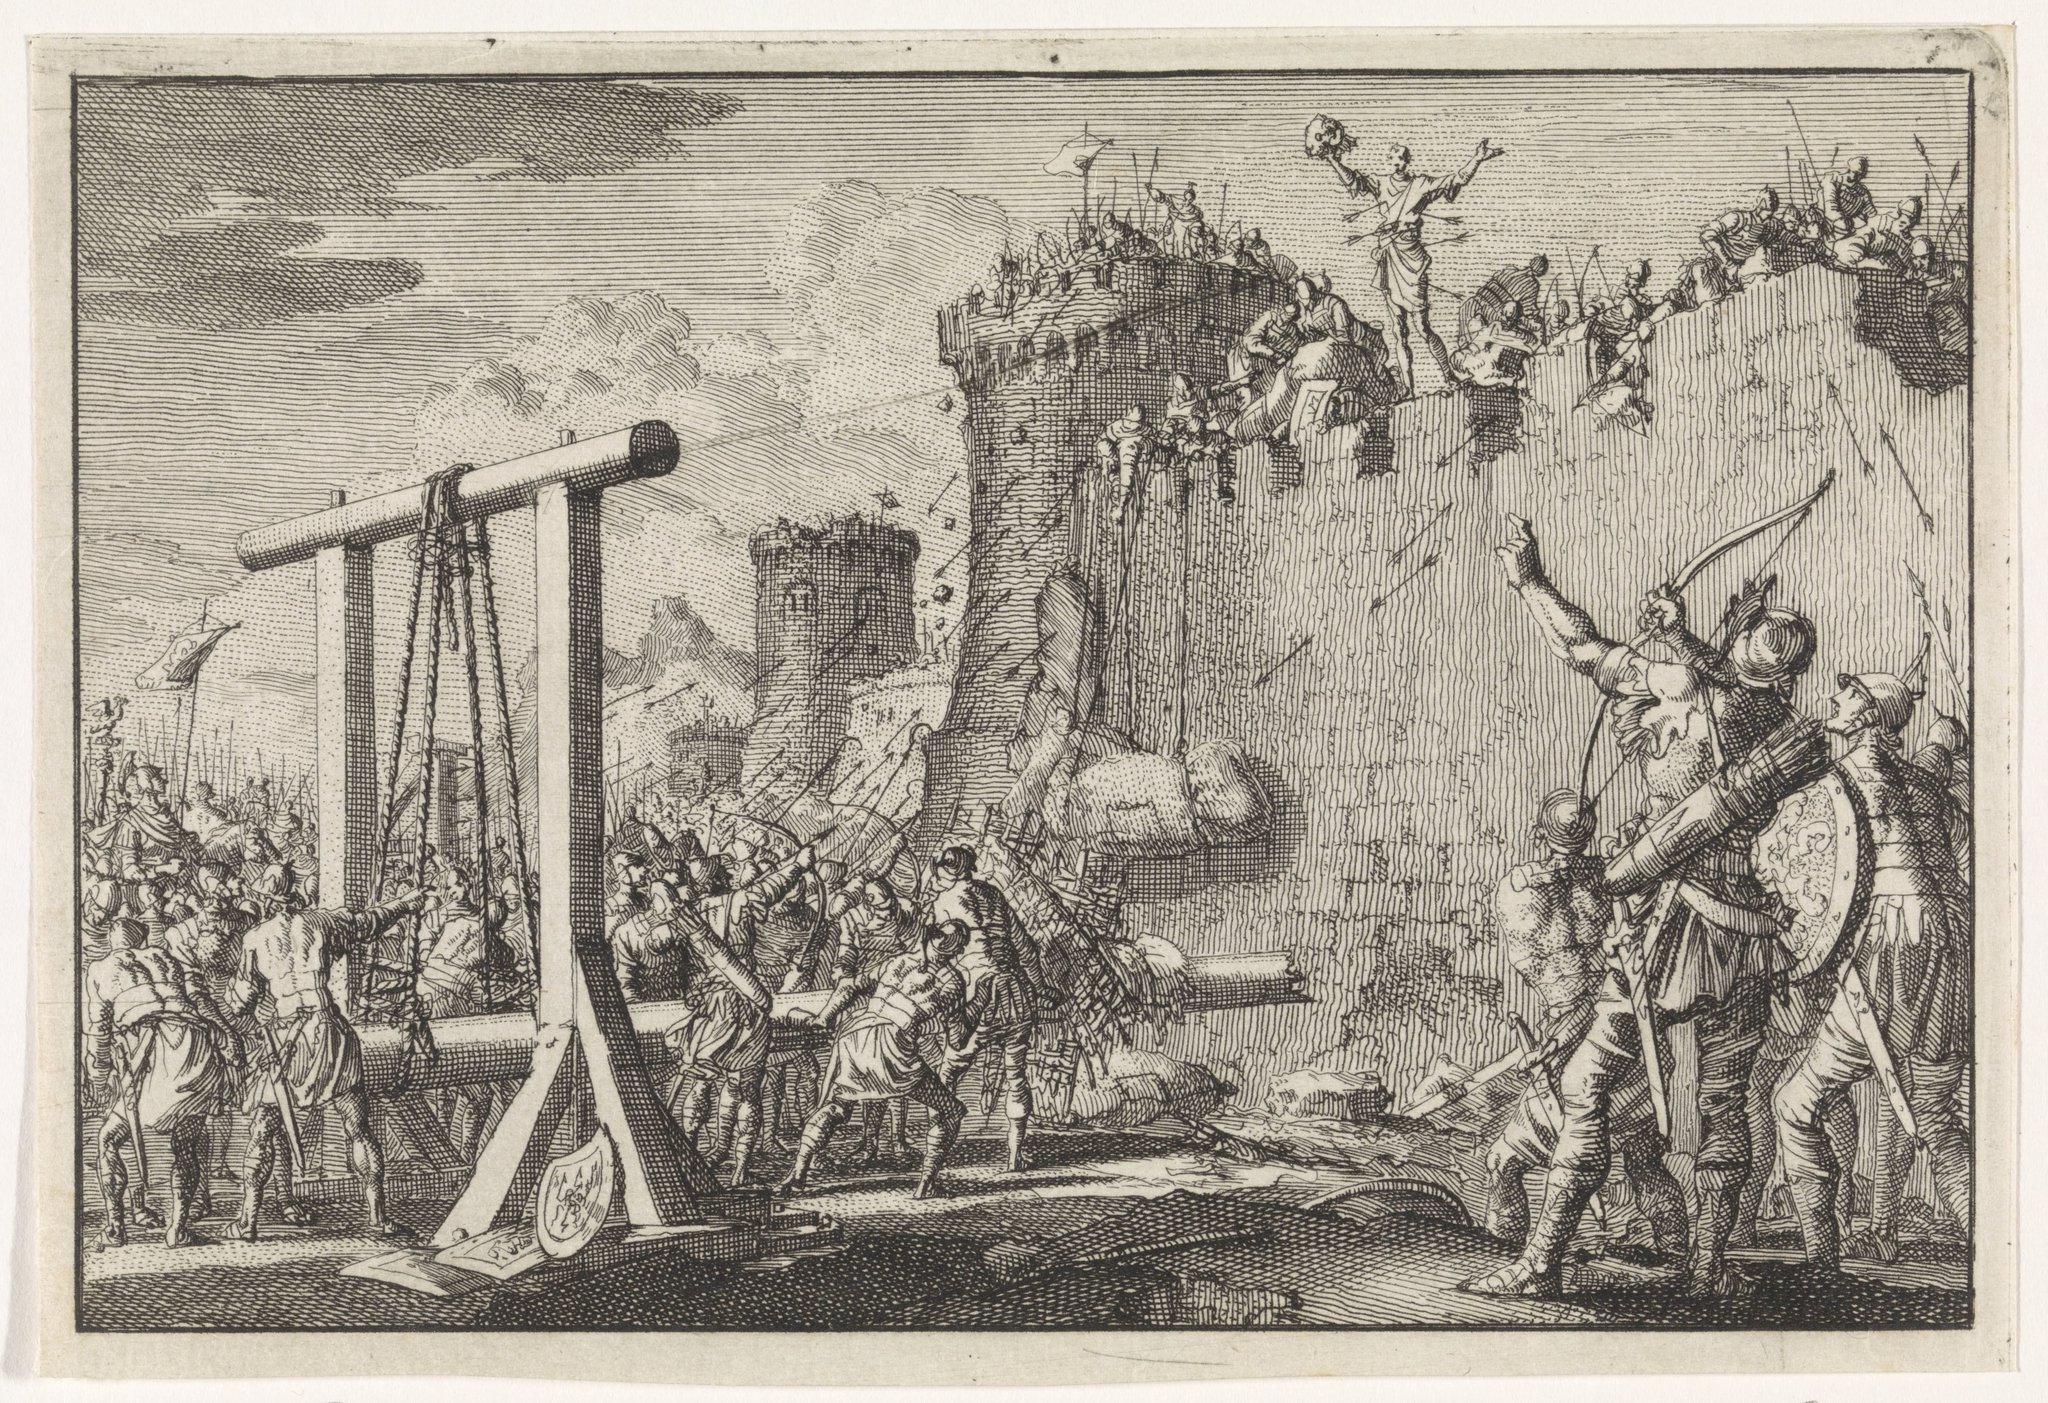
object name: print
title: Beleg van Jotapata door de Romeinen onder Vespasianus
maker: jan luyken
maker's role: draughtsman, print maker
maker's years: 1649-1712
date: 1704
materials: paper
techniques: etching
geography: amsterdam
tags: siege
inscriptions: collector's mark: Lugt 2228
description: Prent ook gebruikt als boekillustratie in: Josephus, Flavius. Alle de Werken, 2 delen. Amsterdam: Pieter Mortier, 1704, dl. 2, p. 607.